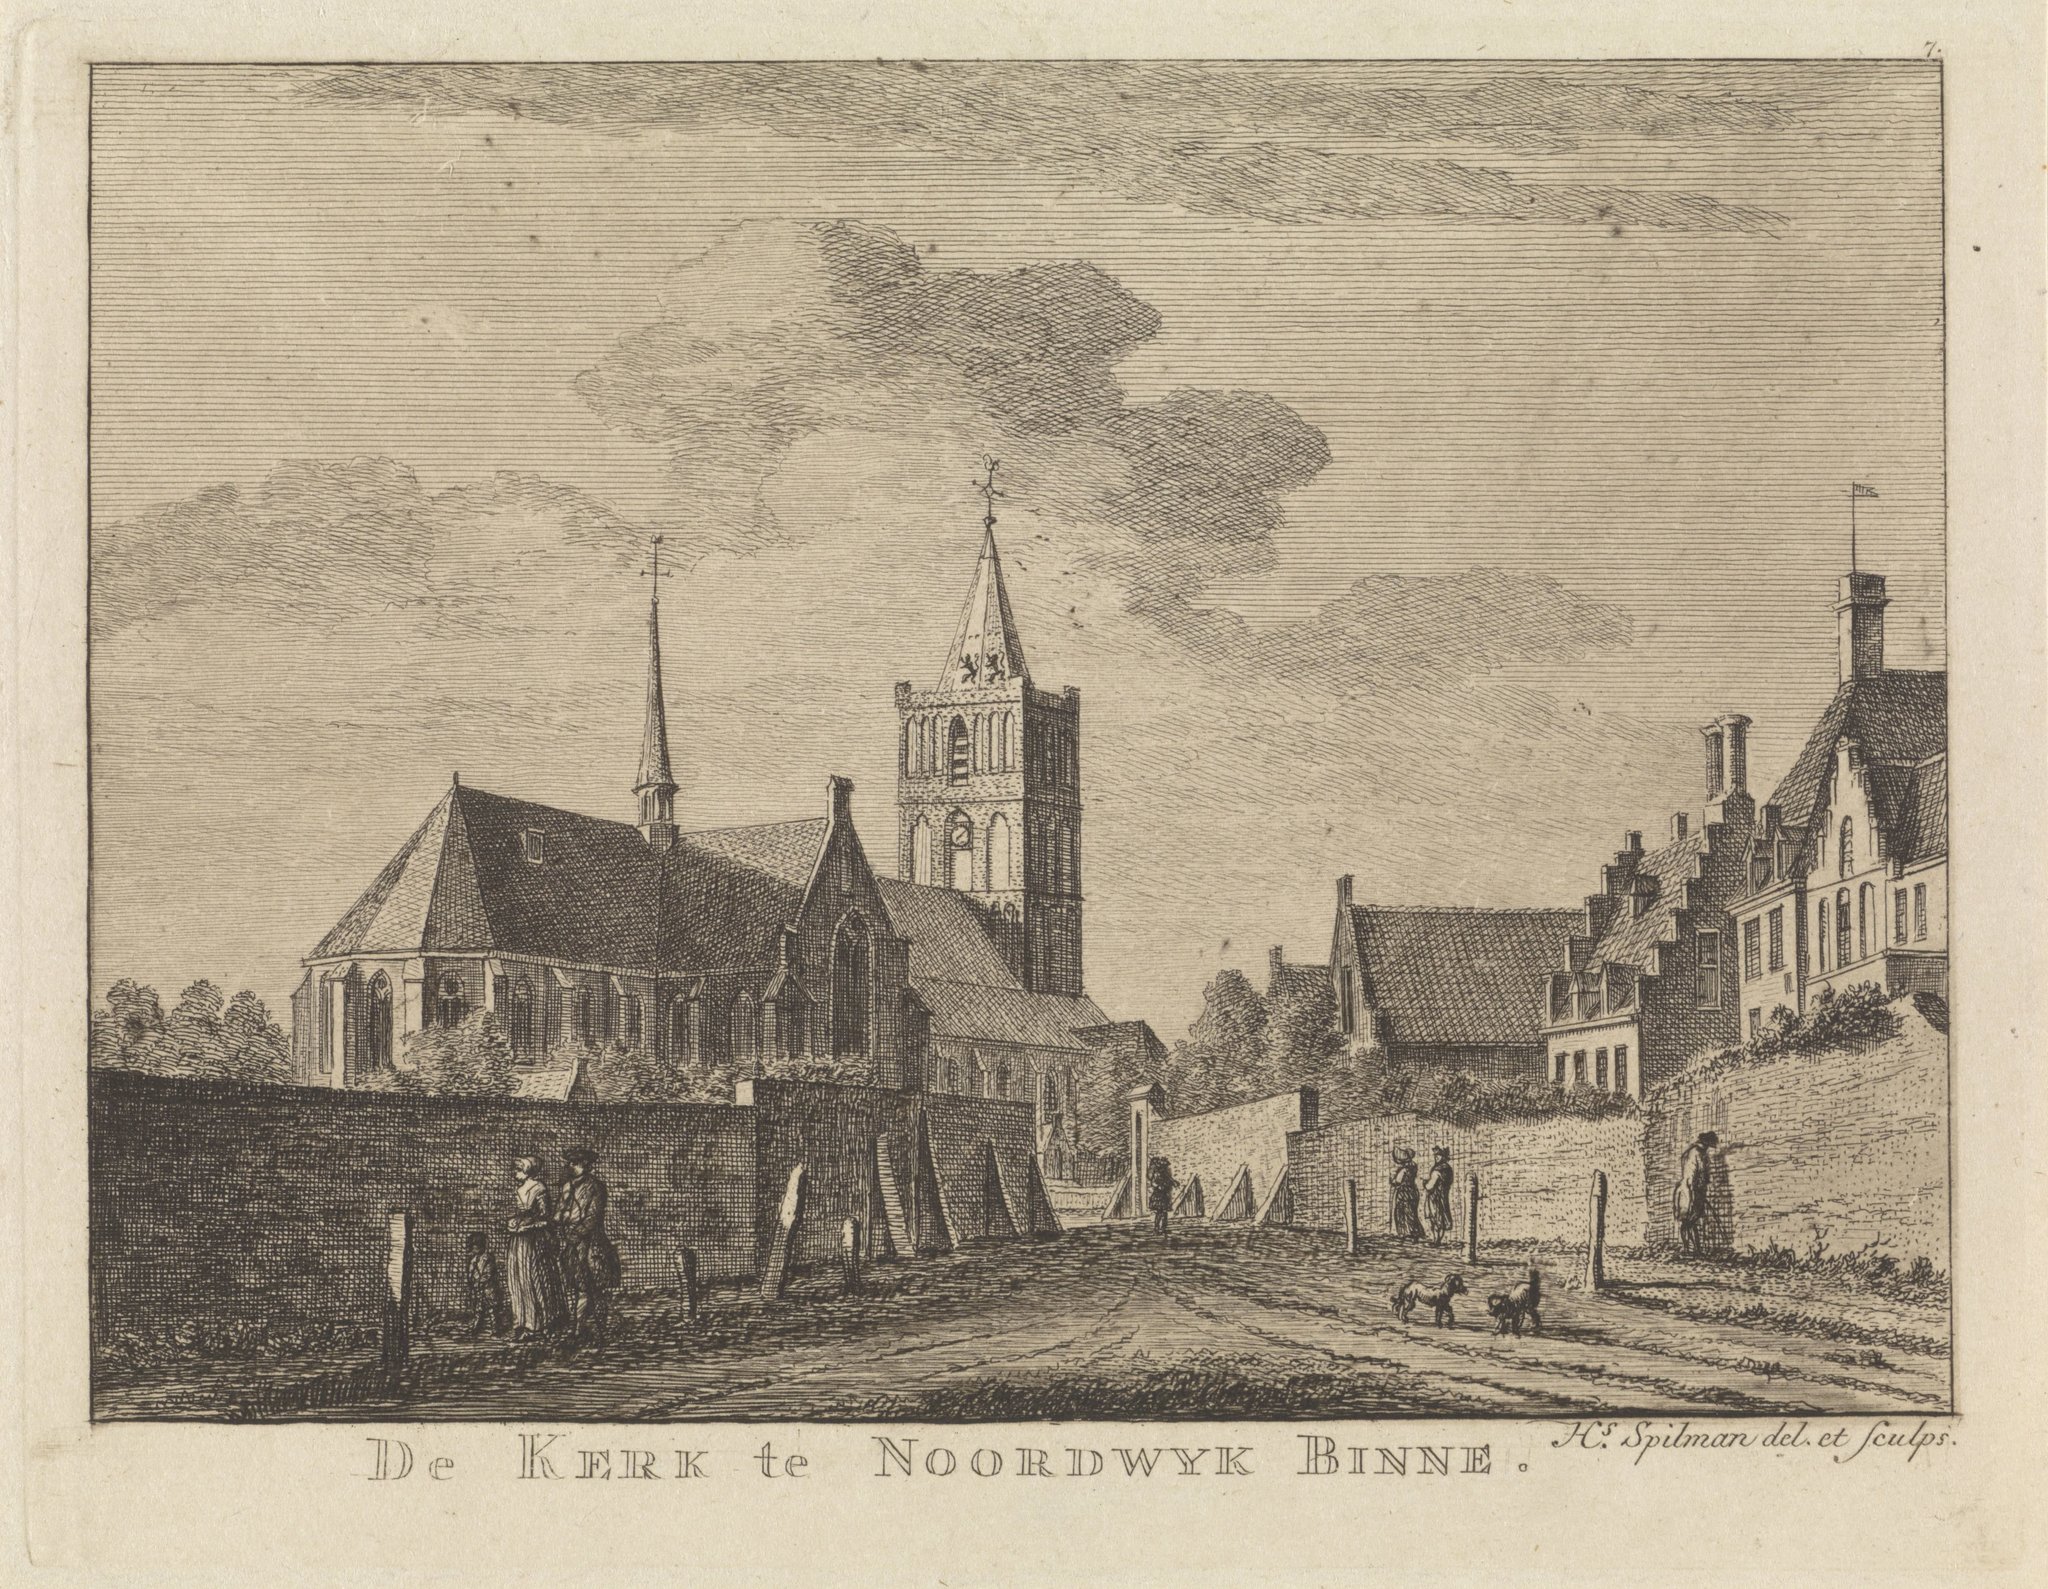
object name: print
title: Gezicht op Noordwijk-Binnen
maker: hendrik spilman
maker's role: draughtsman, painter, print maker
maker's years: 1721-1784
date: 1742-1784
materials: paper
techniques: etching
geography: haarlem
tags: church (exterior), village square, place (+ city(-scape) with figures, staffage)